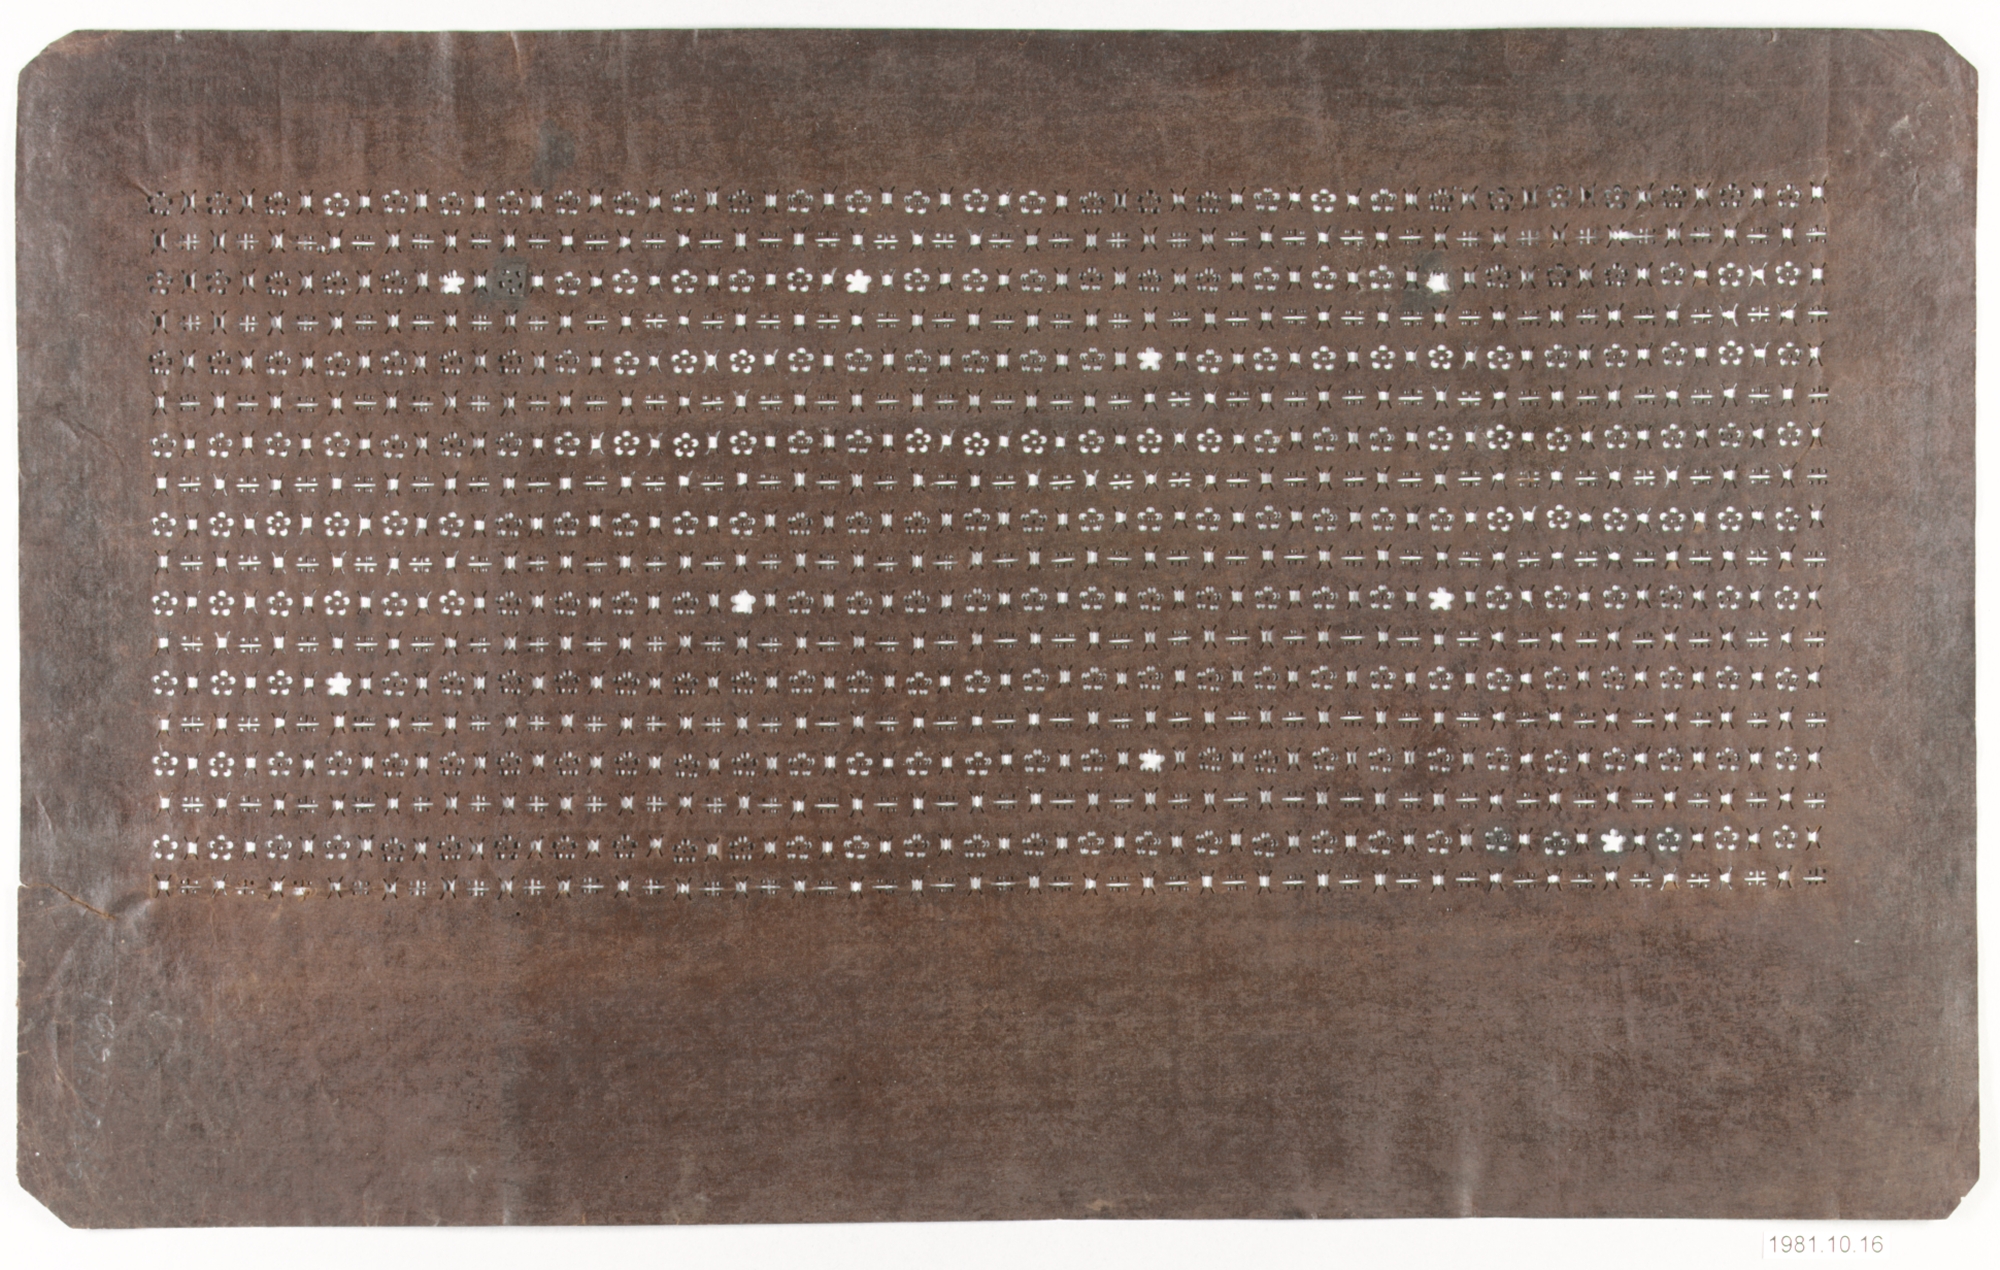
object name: stencil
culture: japanese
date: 1801-1900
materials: paper